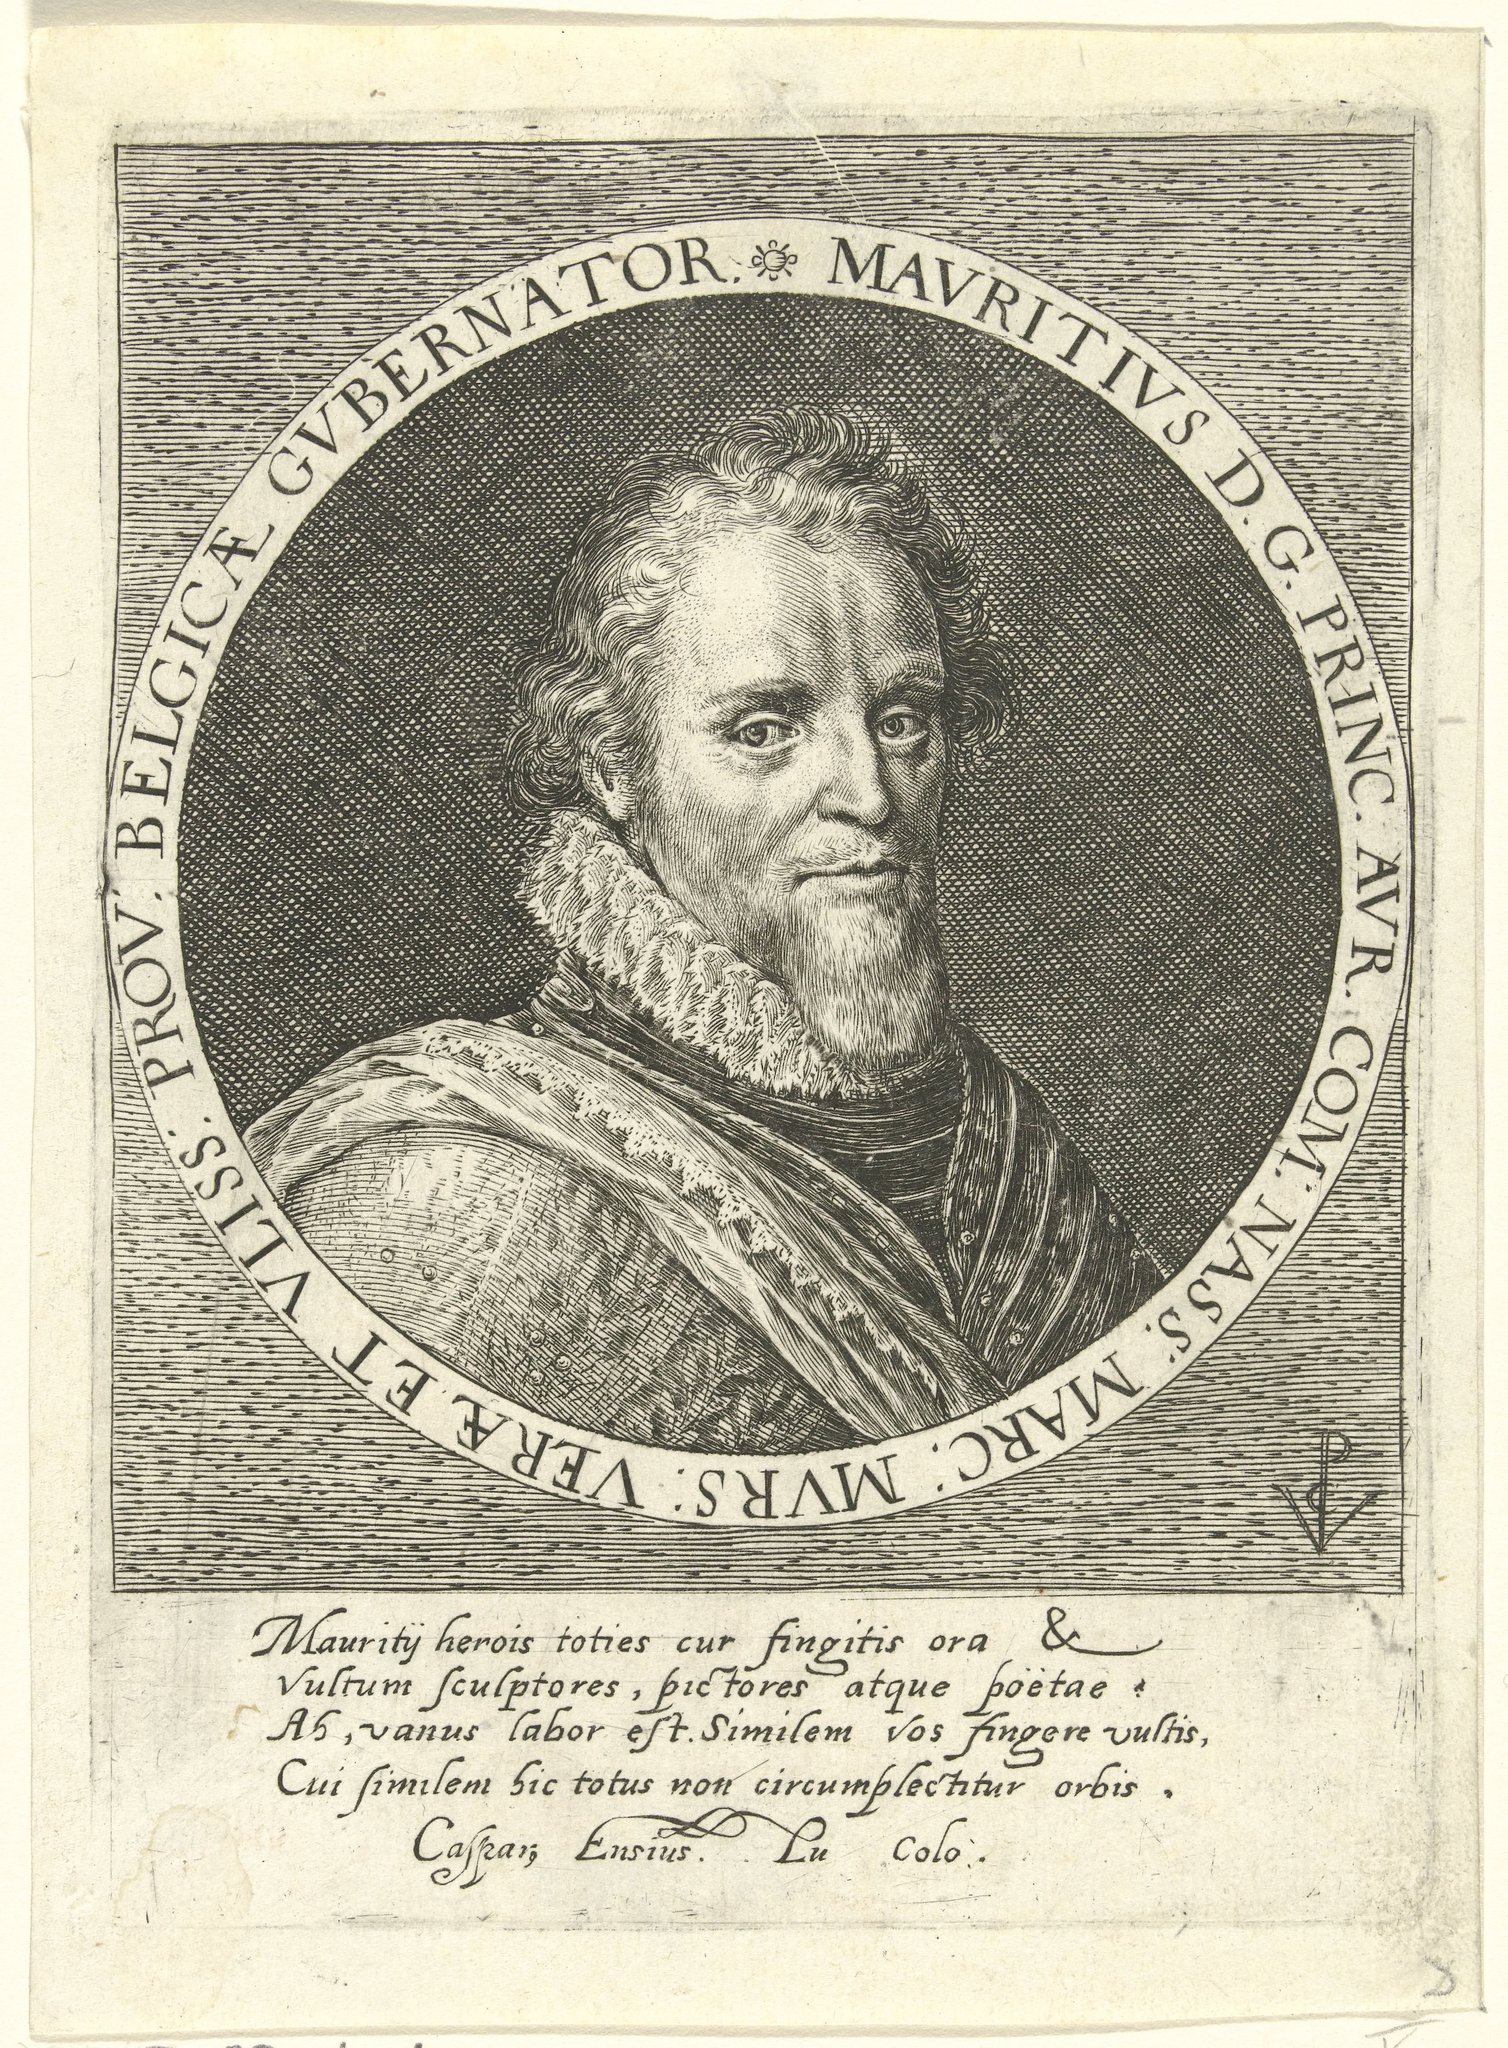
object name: print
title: Portret van Maurits van Oranje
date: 1615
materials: paper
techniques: engraving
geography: utrecht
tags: maurice (prince of orange)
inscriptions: collector's mark: Lugt 2228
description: Portret van Maurits, prins van Oranje, graaf van Nassau. In het randschrift van de omlijsting de naam en functie van de geportretteerde in het Latijn. In de marge een vierregelig lofdicht in het Latijn.